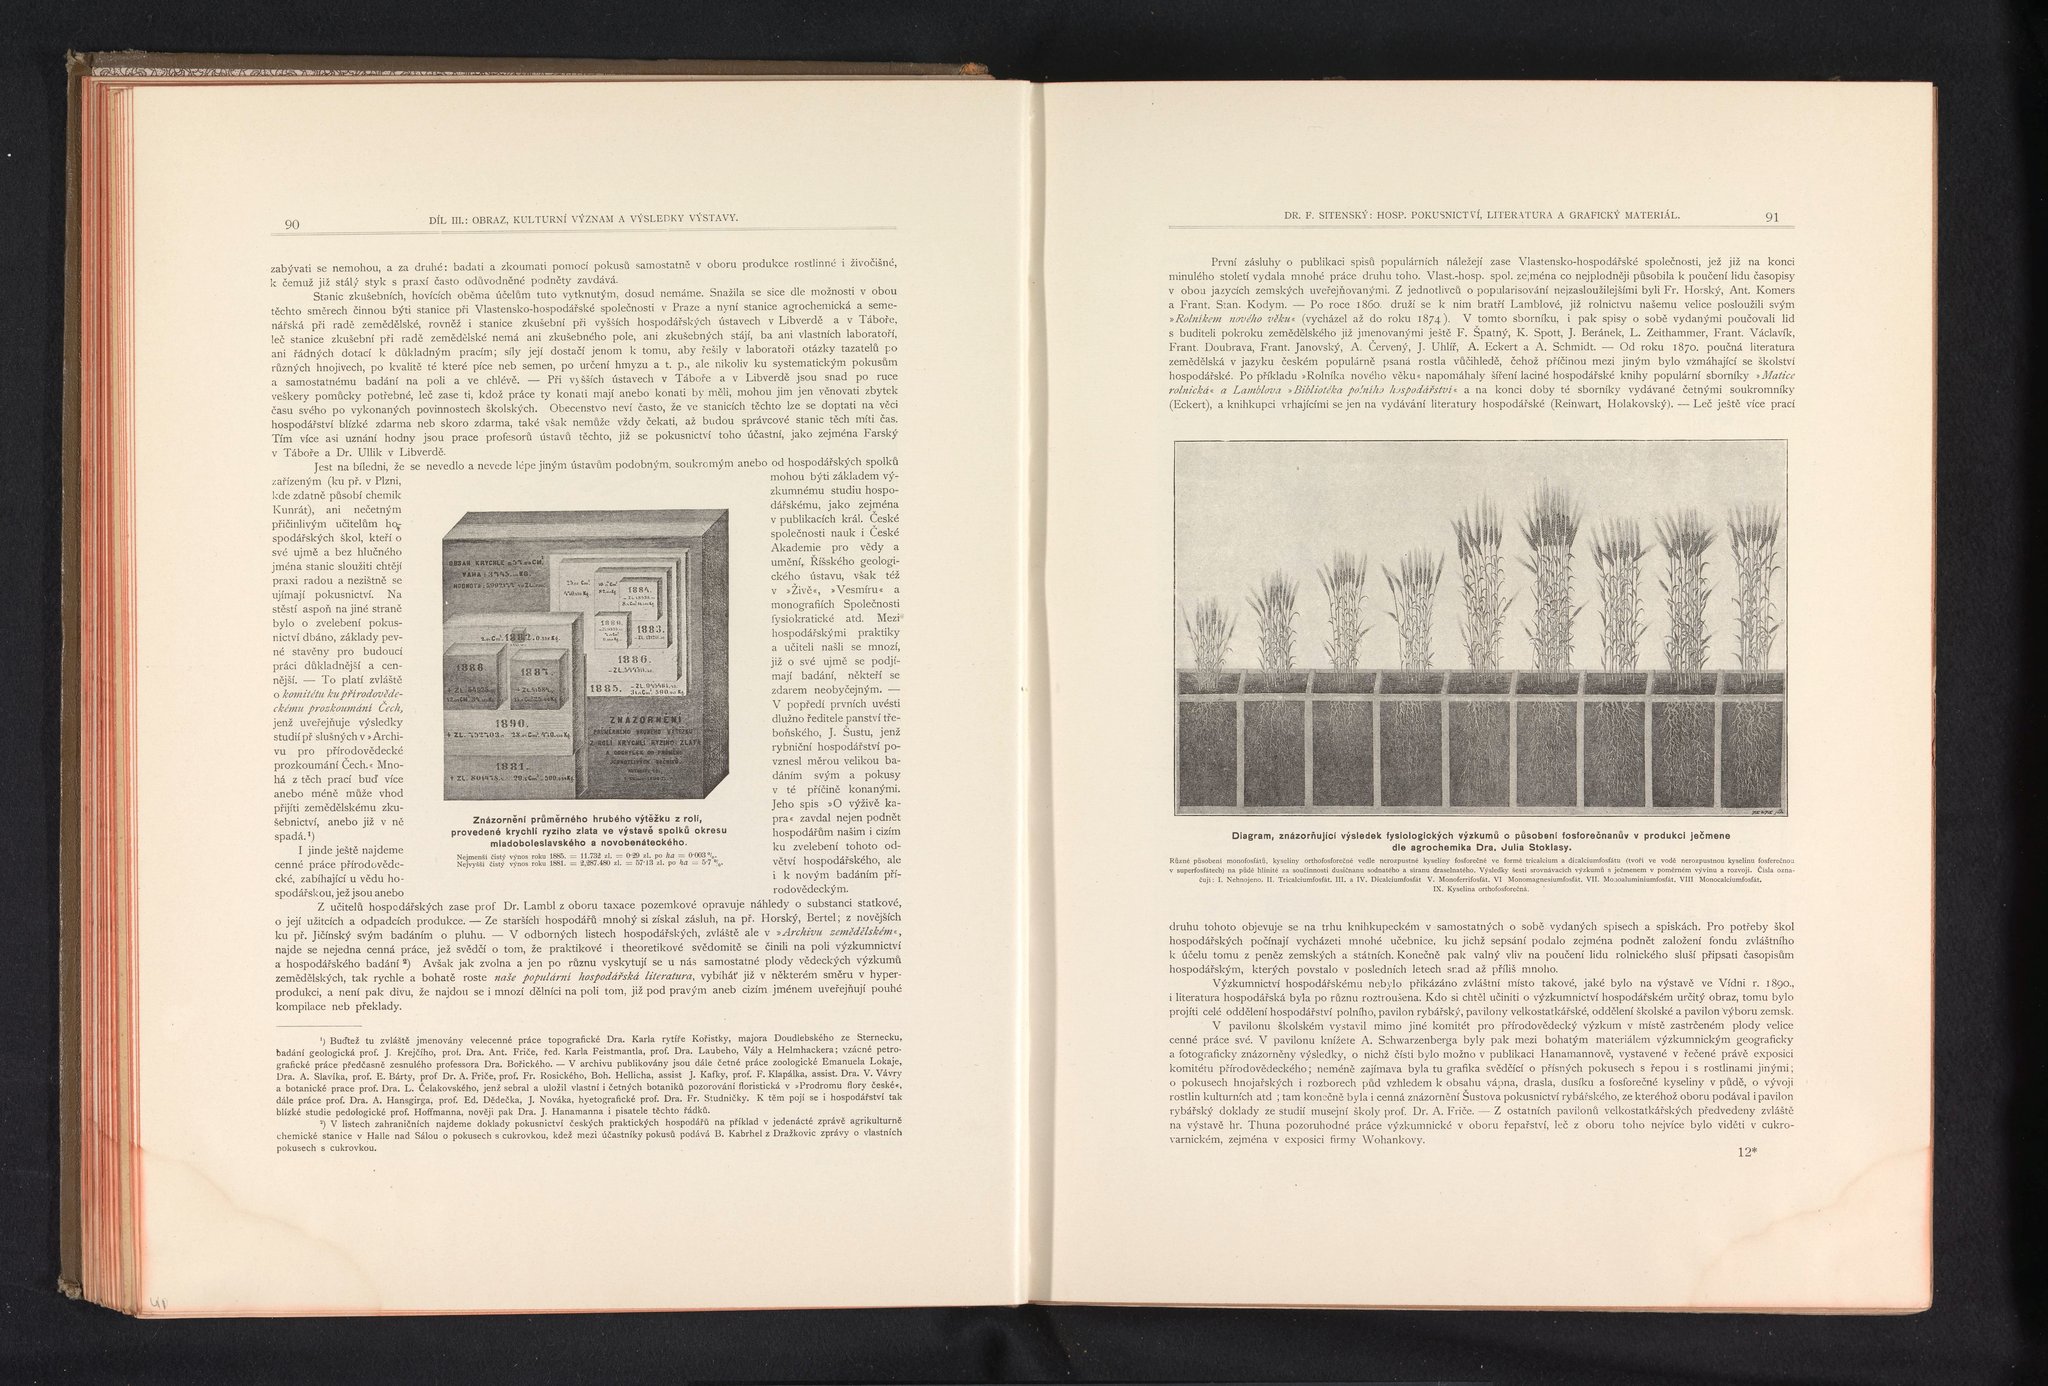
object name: reproduction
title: Diagram, znázornujici výsledek fysiologických výzkumu o pusobeni fosforecnanuv v produkci jecmene dle agrochemika Dra. Julia Stoklasy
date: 1891-1895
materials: paper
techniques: autotype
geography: prague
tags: field filled with a crop